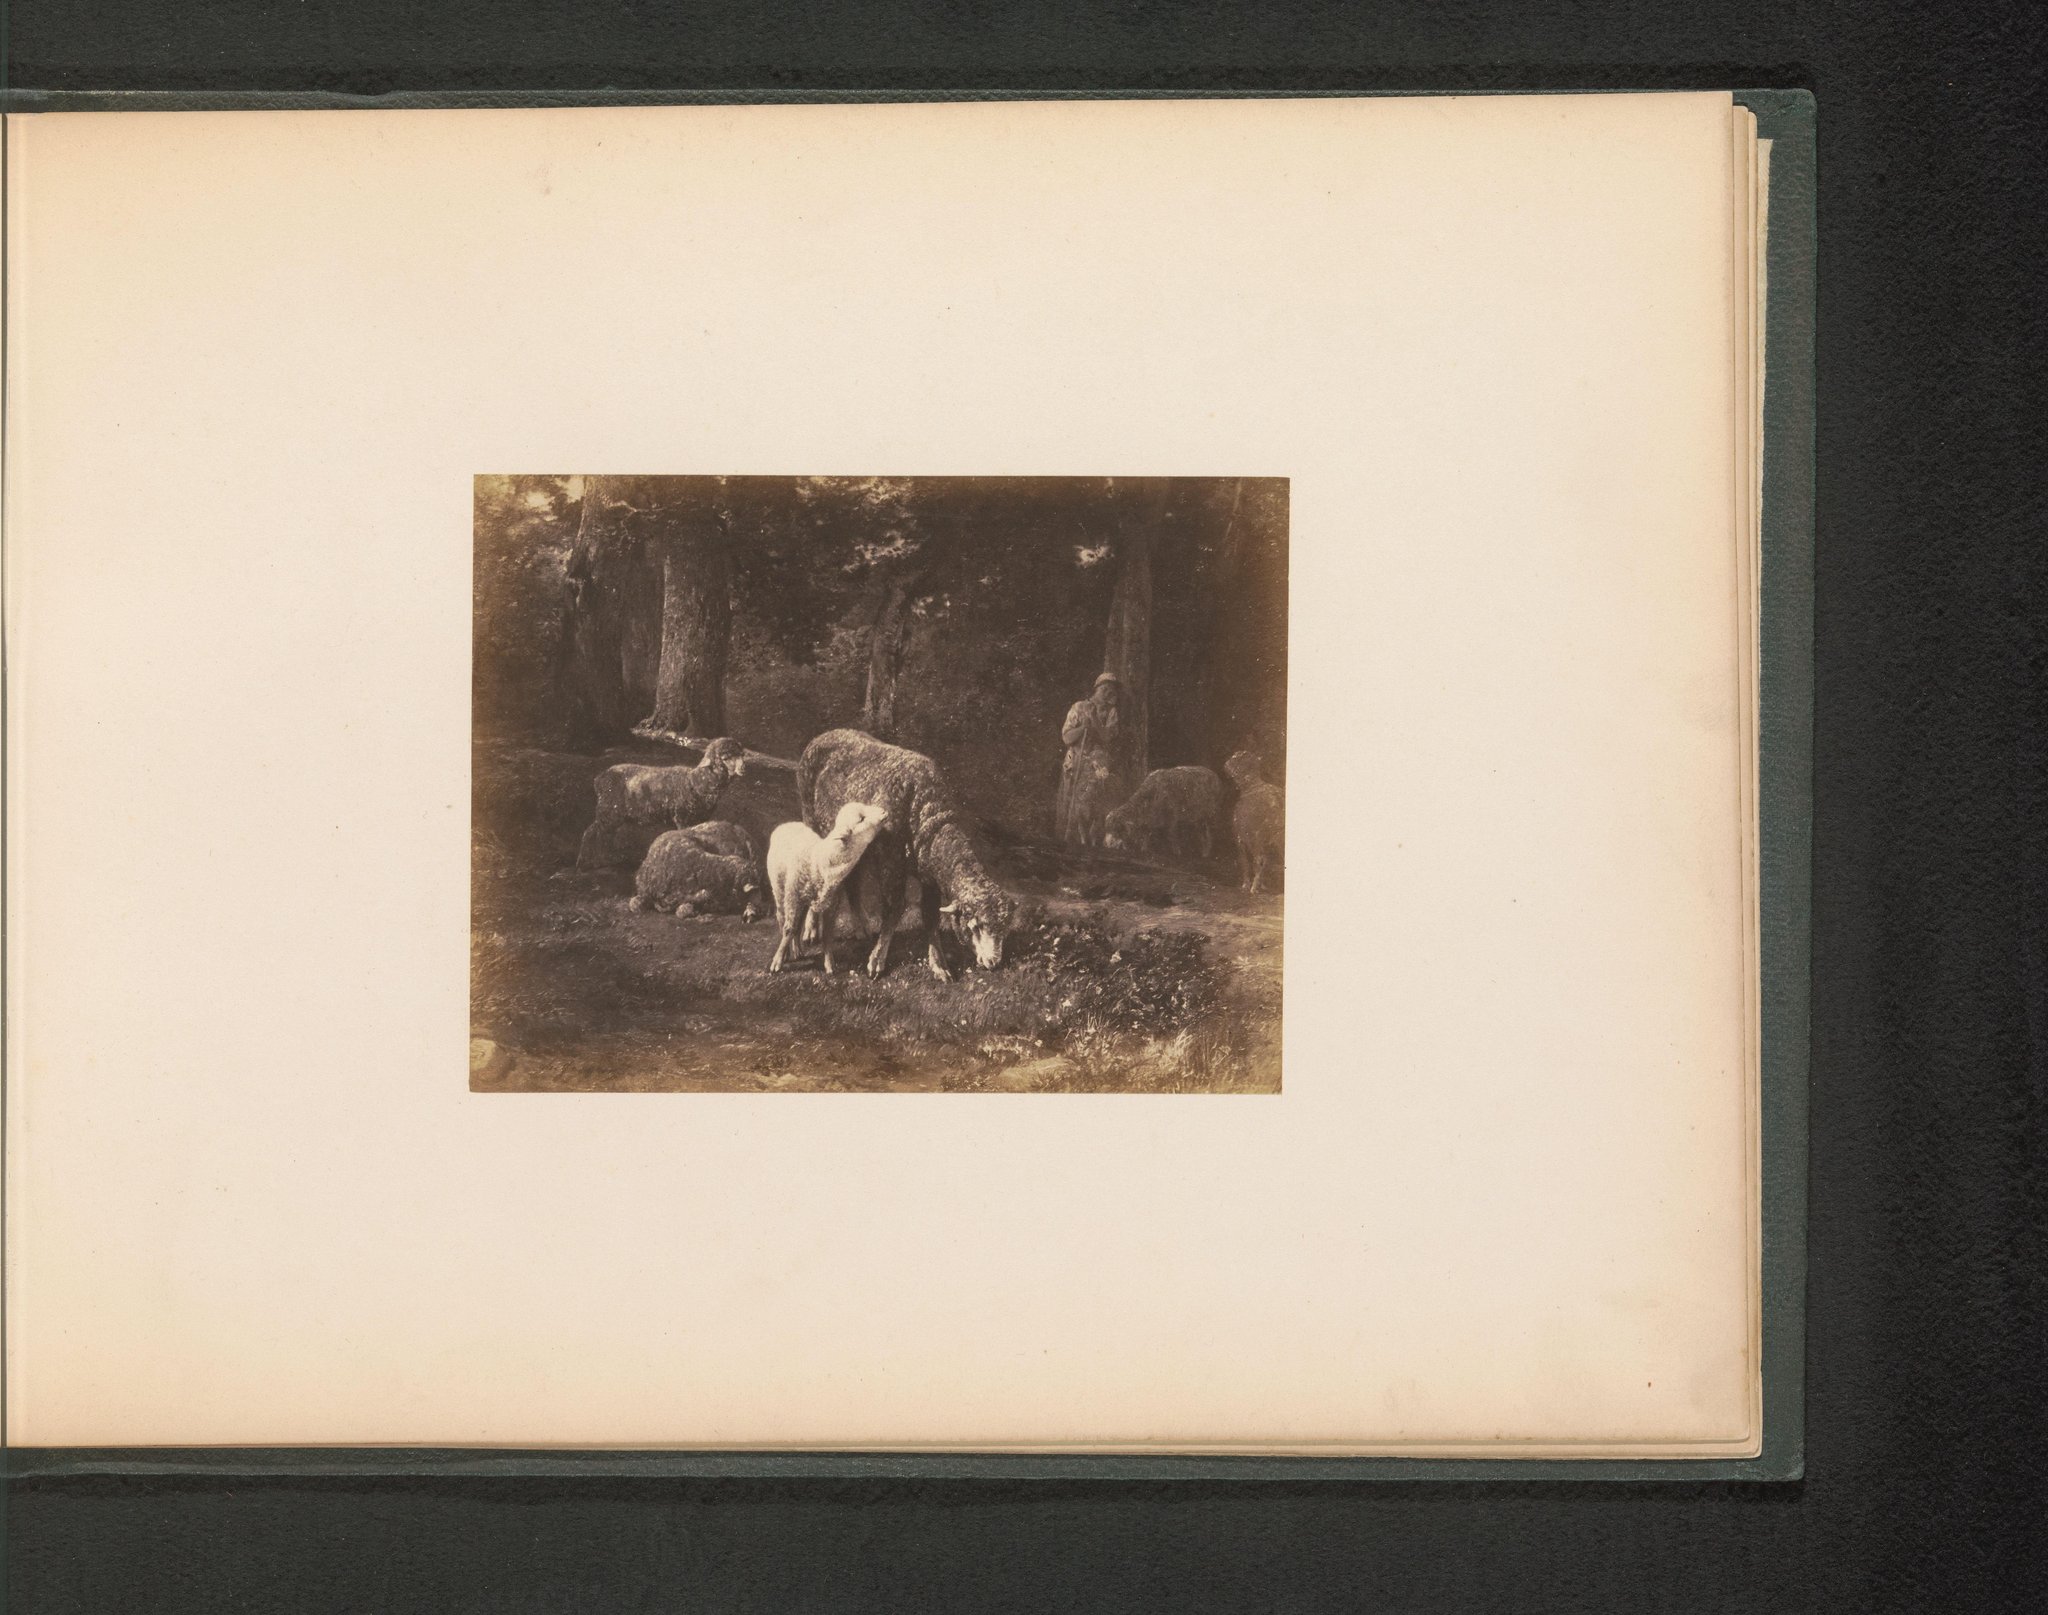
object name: reproduction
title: Fotoreproductie van Moutons dans le bois van Ch. Jacques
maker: Anonymous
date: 1858-1863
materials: photographic support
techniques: albumen print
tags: trees, sheep, picture, painting